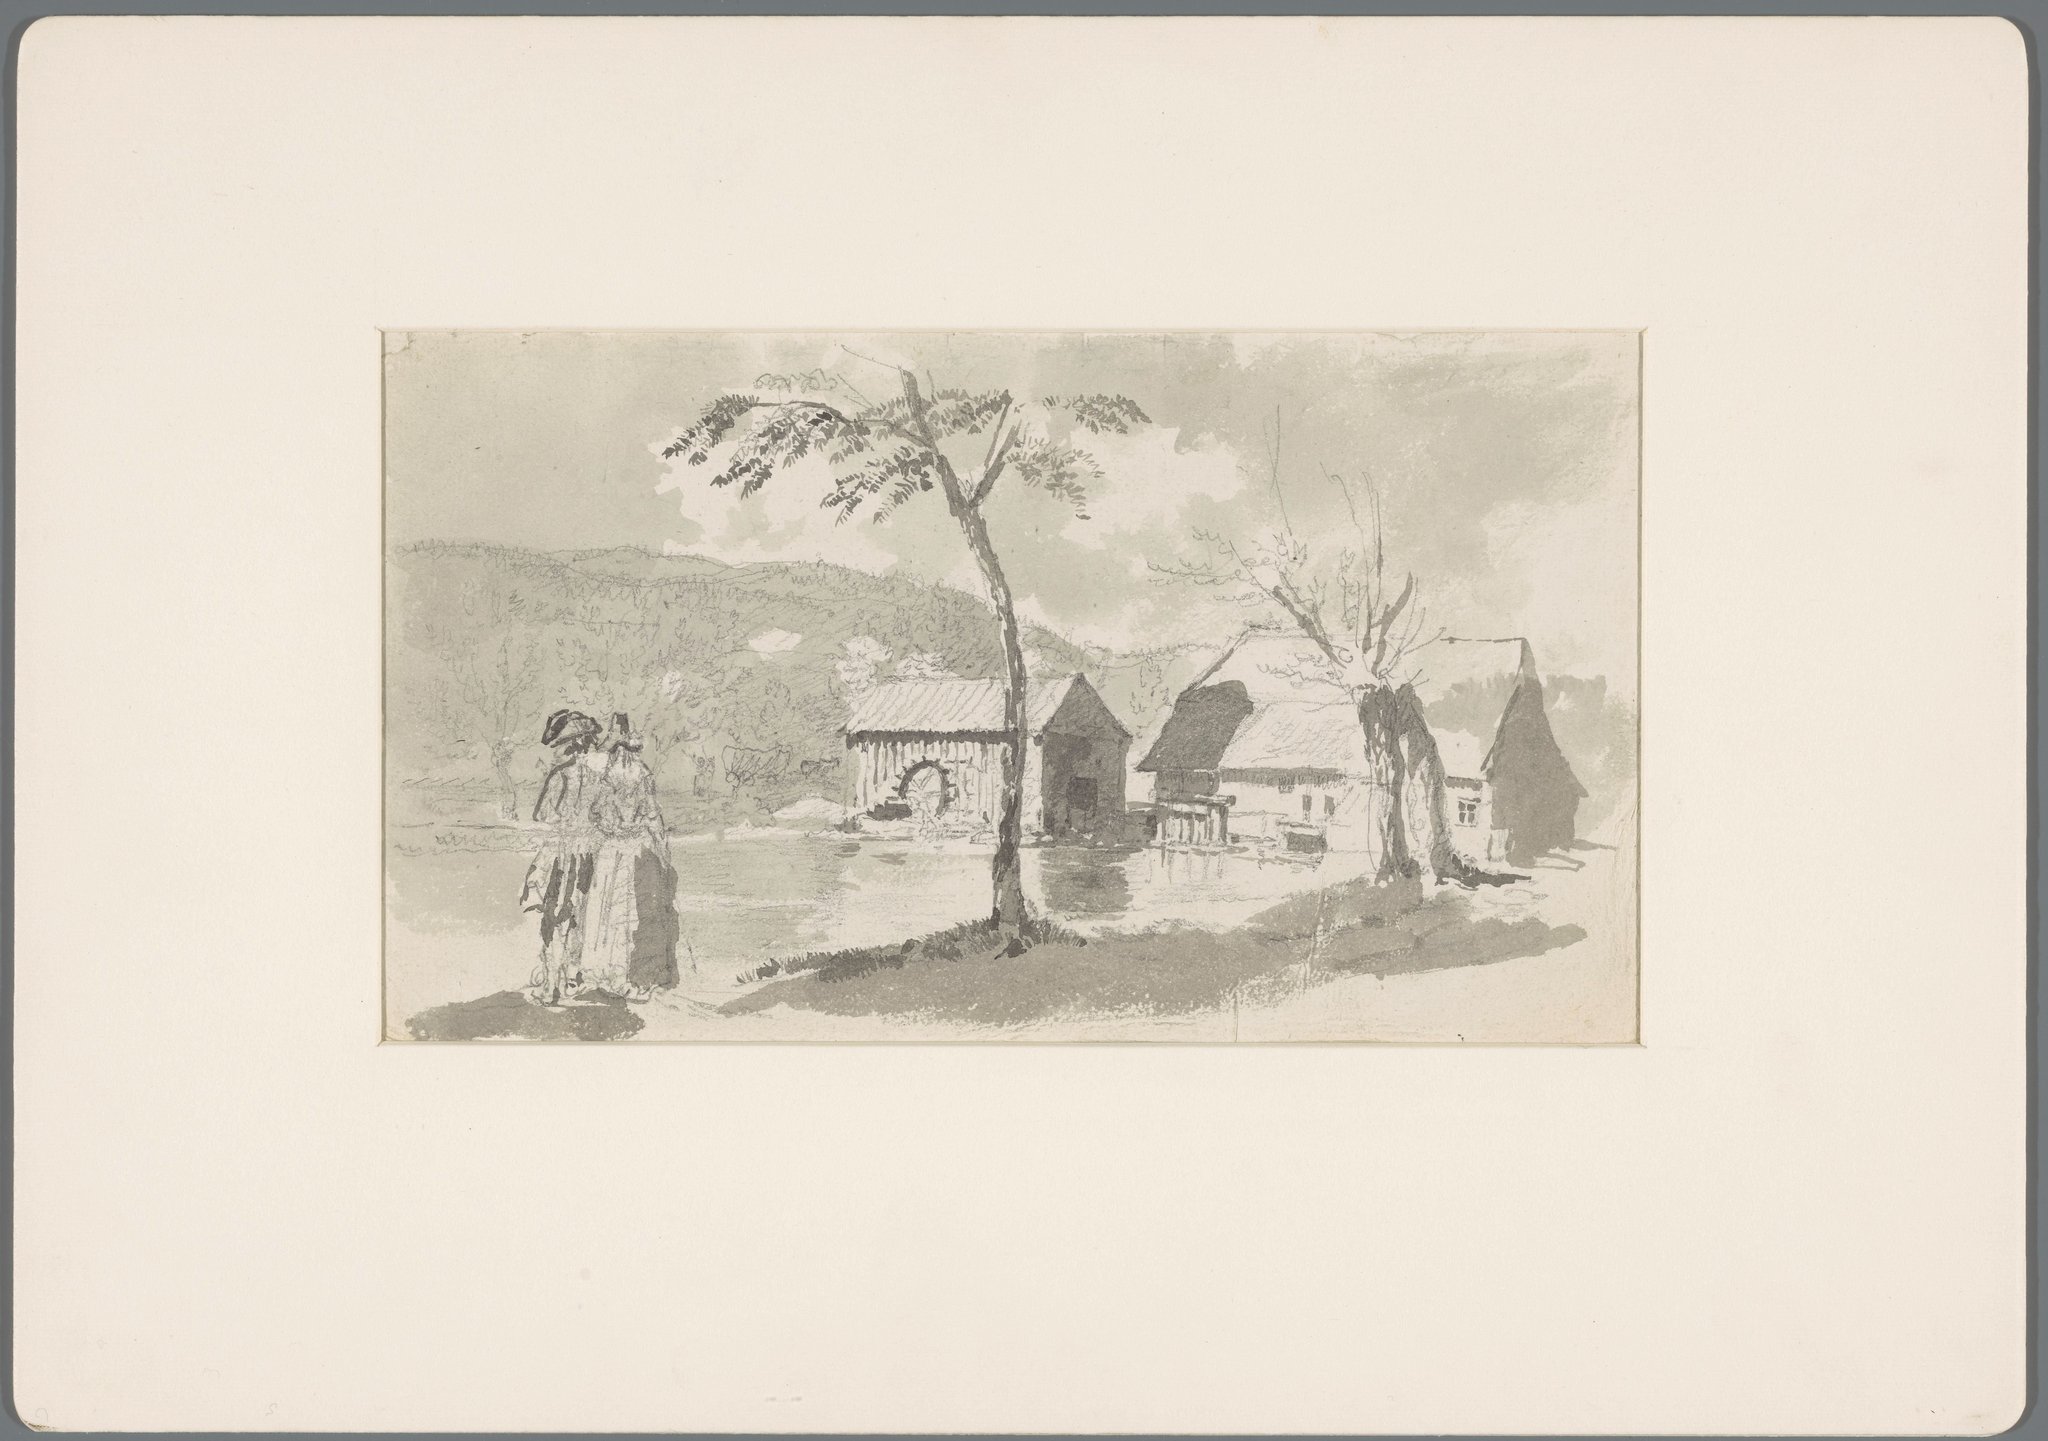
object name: drawing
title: Boerderij met watermolen aan een bergmeer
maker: david alphonse de sandoz-rollin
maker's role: draughtsman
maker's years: 1740-1809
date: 1750-1809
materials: paper, pencil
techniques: brush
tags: watermill in landscape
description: Boerderij met watermolen aan een bergmeer; op de voorgrond een echtpaar, gearmd hiernaar kijkend, op de rug gezien.